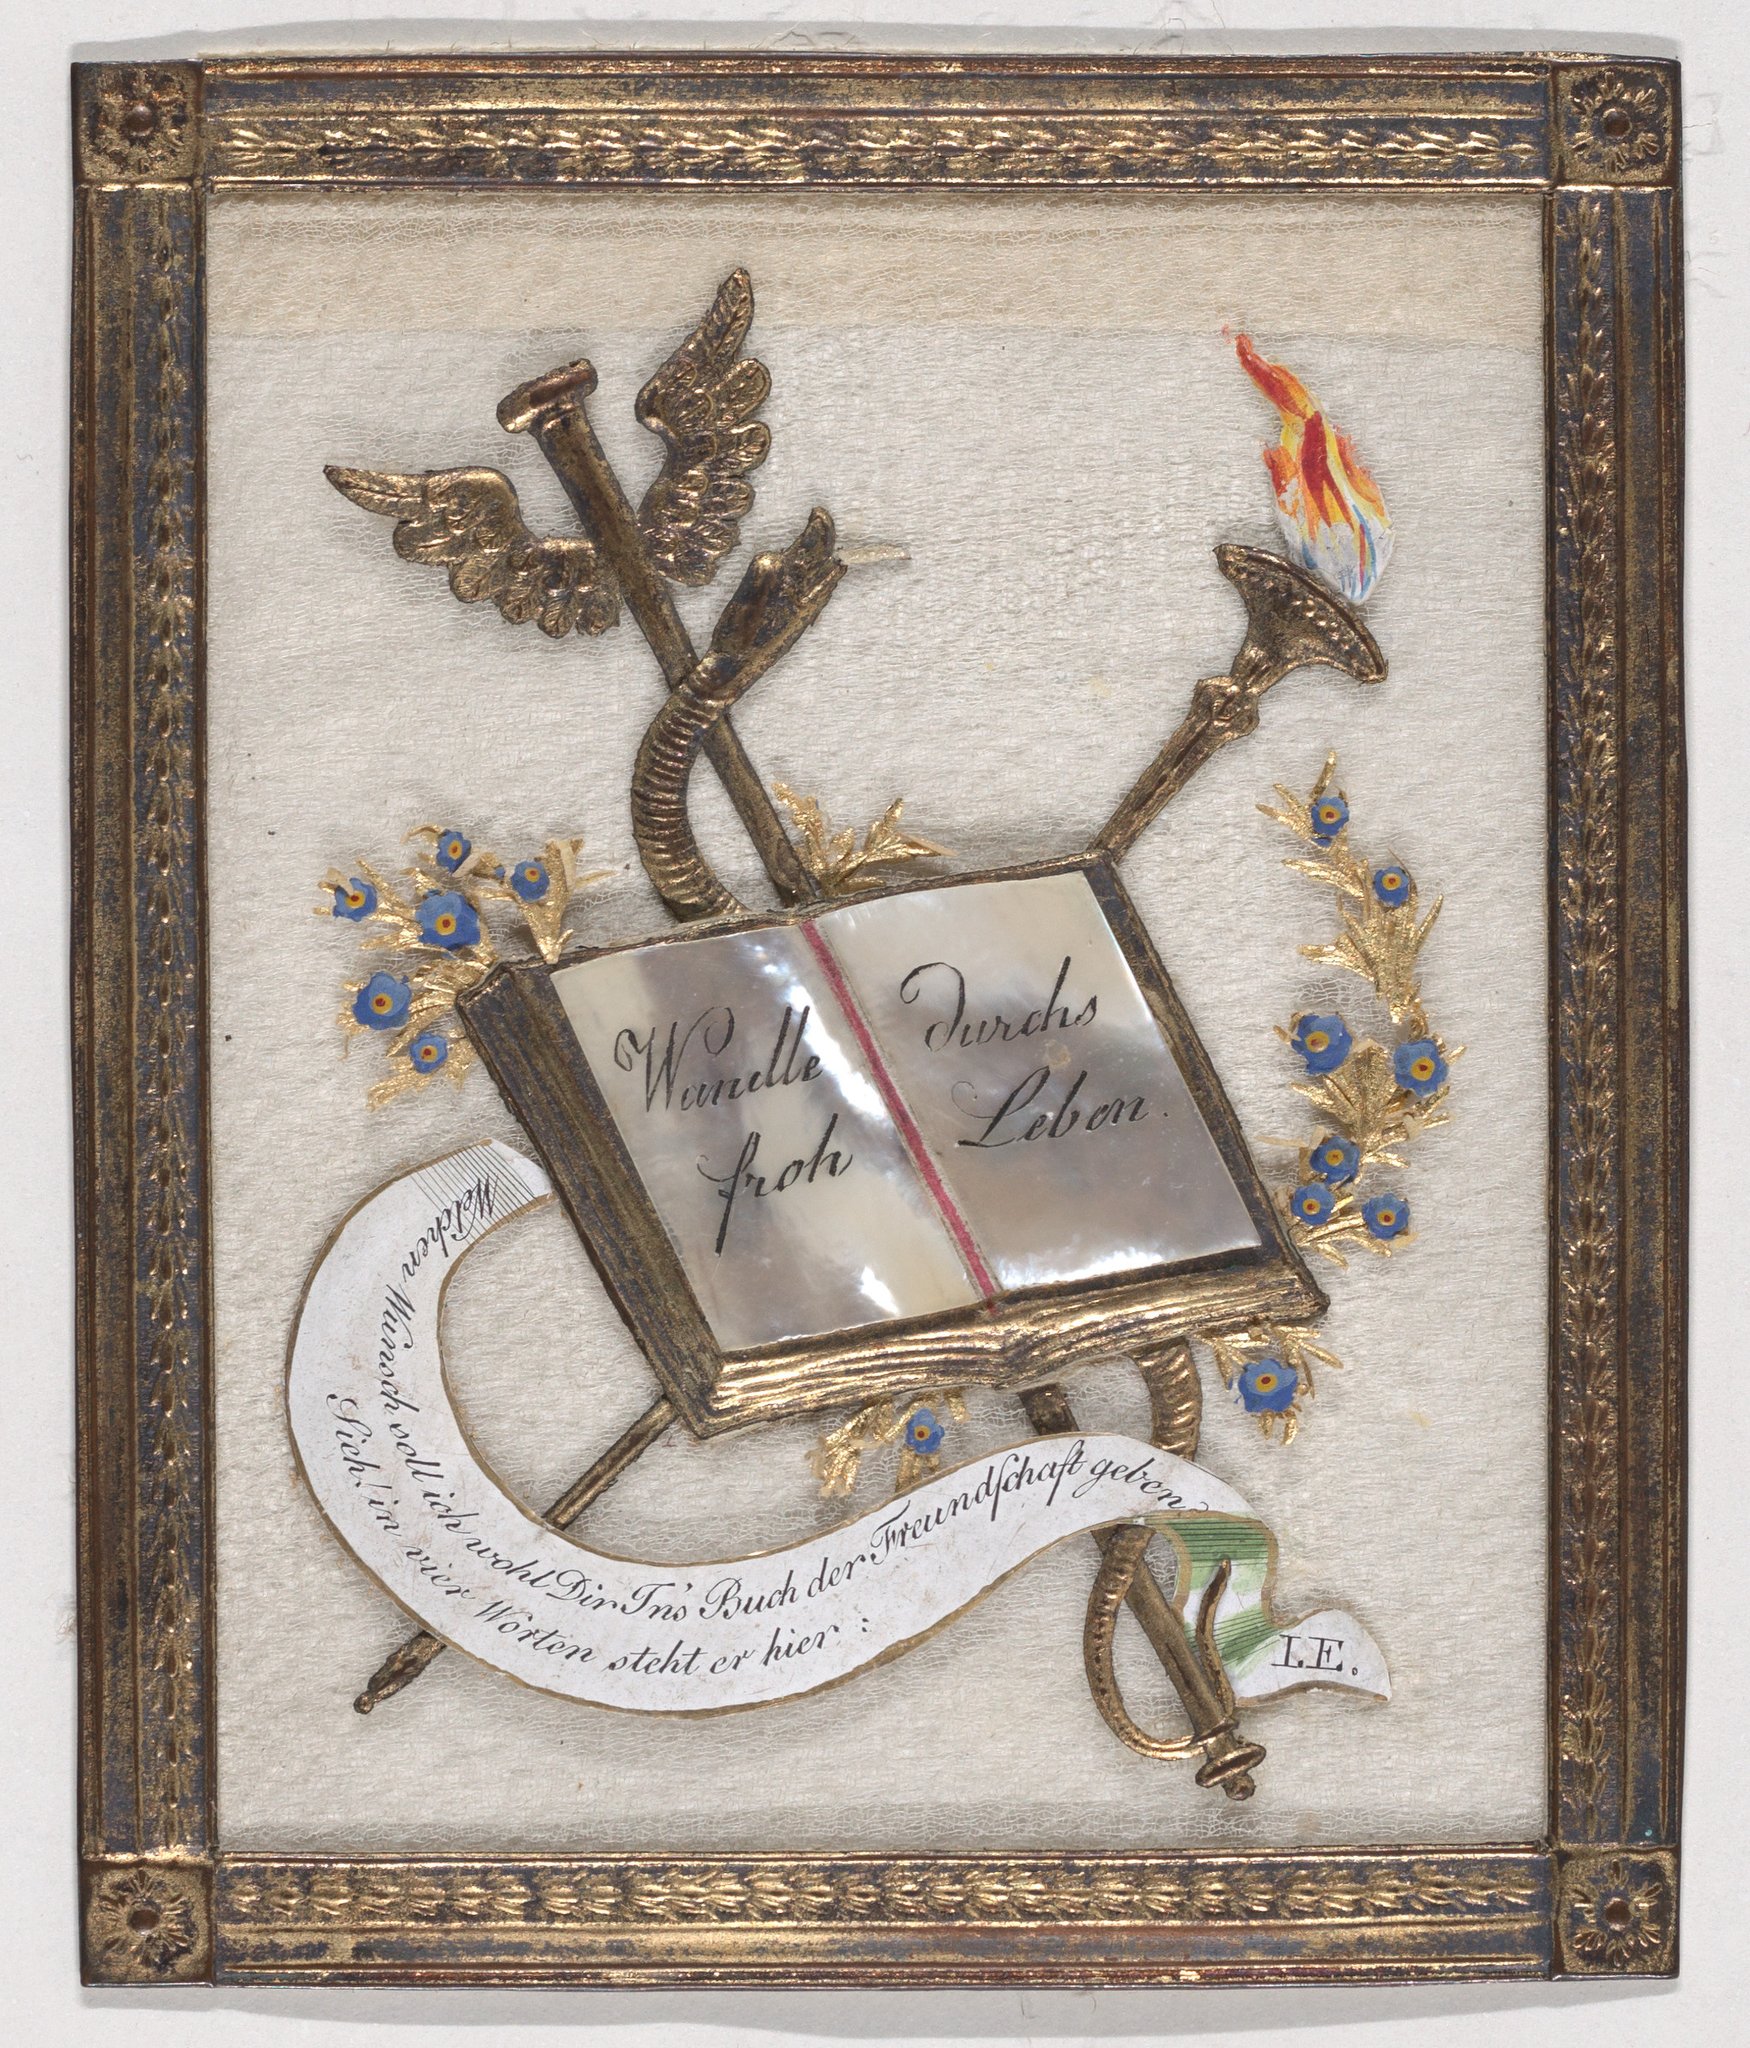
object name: greeting card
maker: johannes endletzberger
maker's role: artist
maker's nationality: austrian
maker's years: 1782-1850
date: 1825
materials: foil, gouache, mother of pearl, paint, paper, silk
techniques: carving, embossing, painting